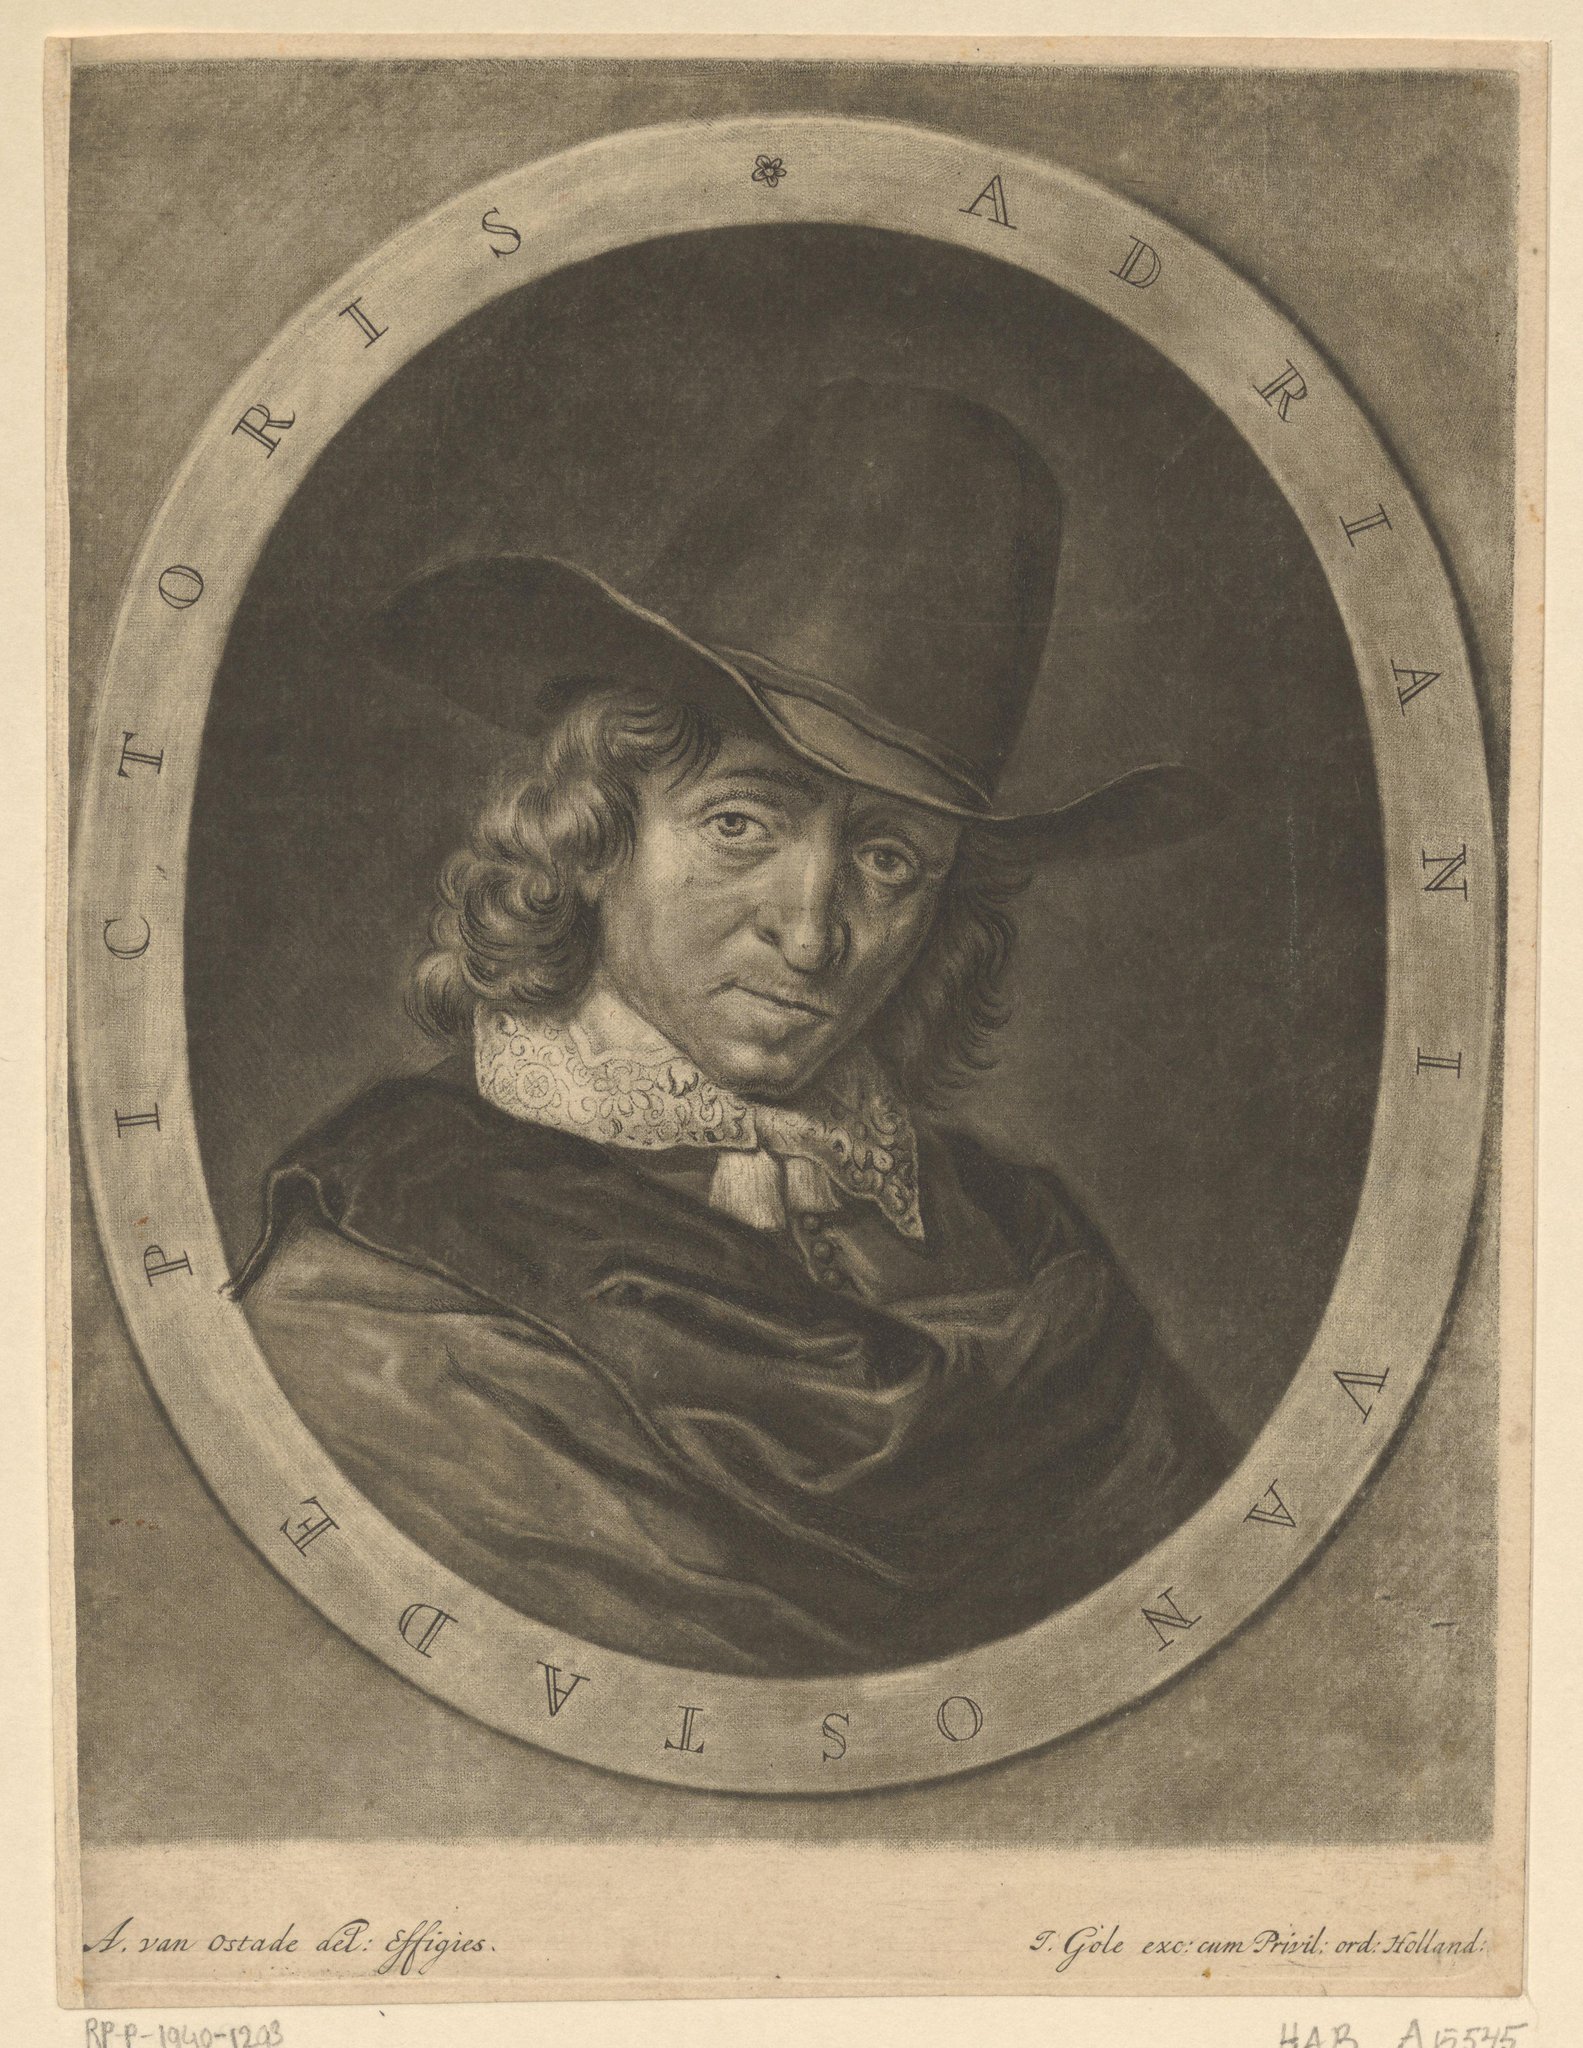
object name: print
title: Portret van Adriaen van Ostade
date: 1682-1723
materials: paper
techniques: engraving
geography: amsterdam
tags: haarlem, painter, adriaen van ostade, historical persons, portrait, self-portrait of painter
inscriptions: collector's mark: Lugt 2760, collector's mark: Lugt 2228